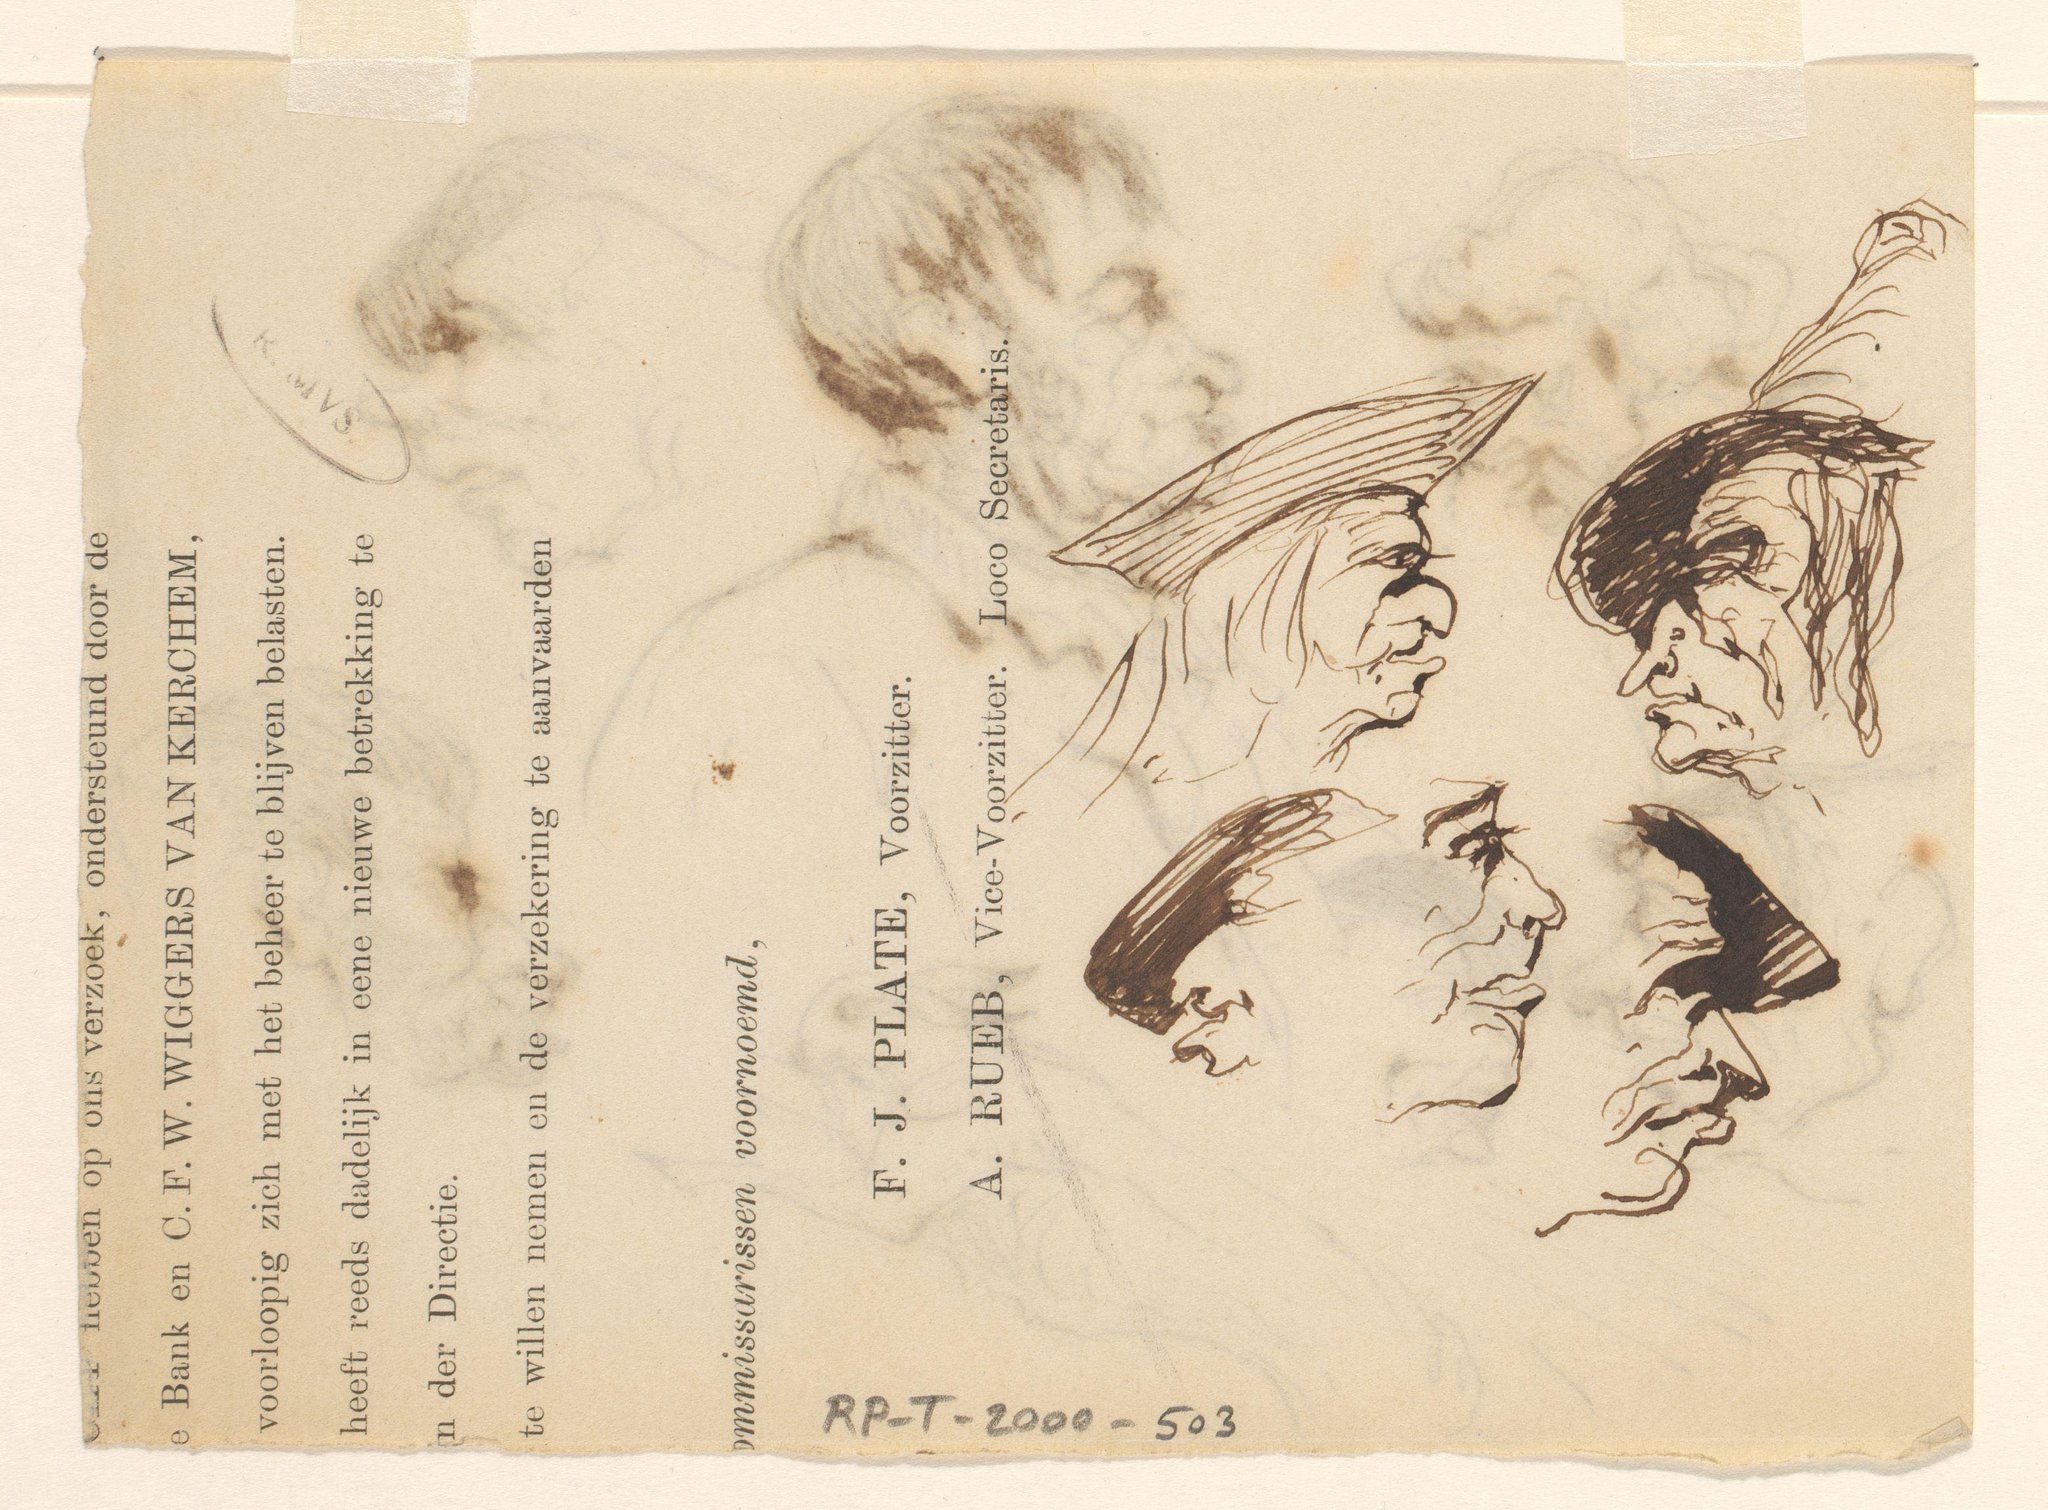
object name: drawing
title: Enkele koppen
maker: johannes tavenraat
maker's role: draughtsman, painter, print maker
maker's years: 1809-1881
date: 1840-1880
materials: ink, paper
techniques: pen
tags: caricatures (human types)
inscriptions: collector's mark: Lugt 2228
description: Enkele koppen. Getekend op een fragment van een administratief drukwerk.